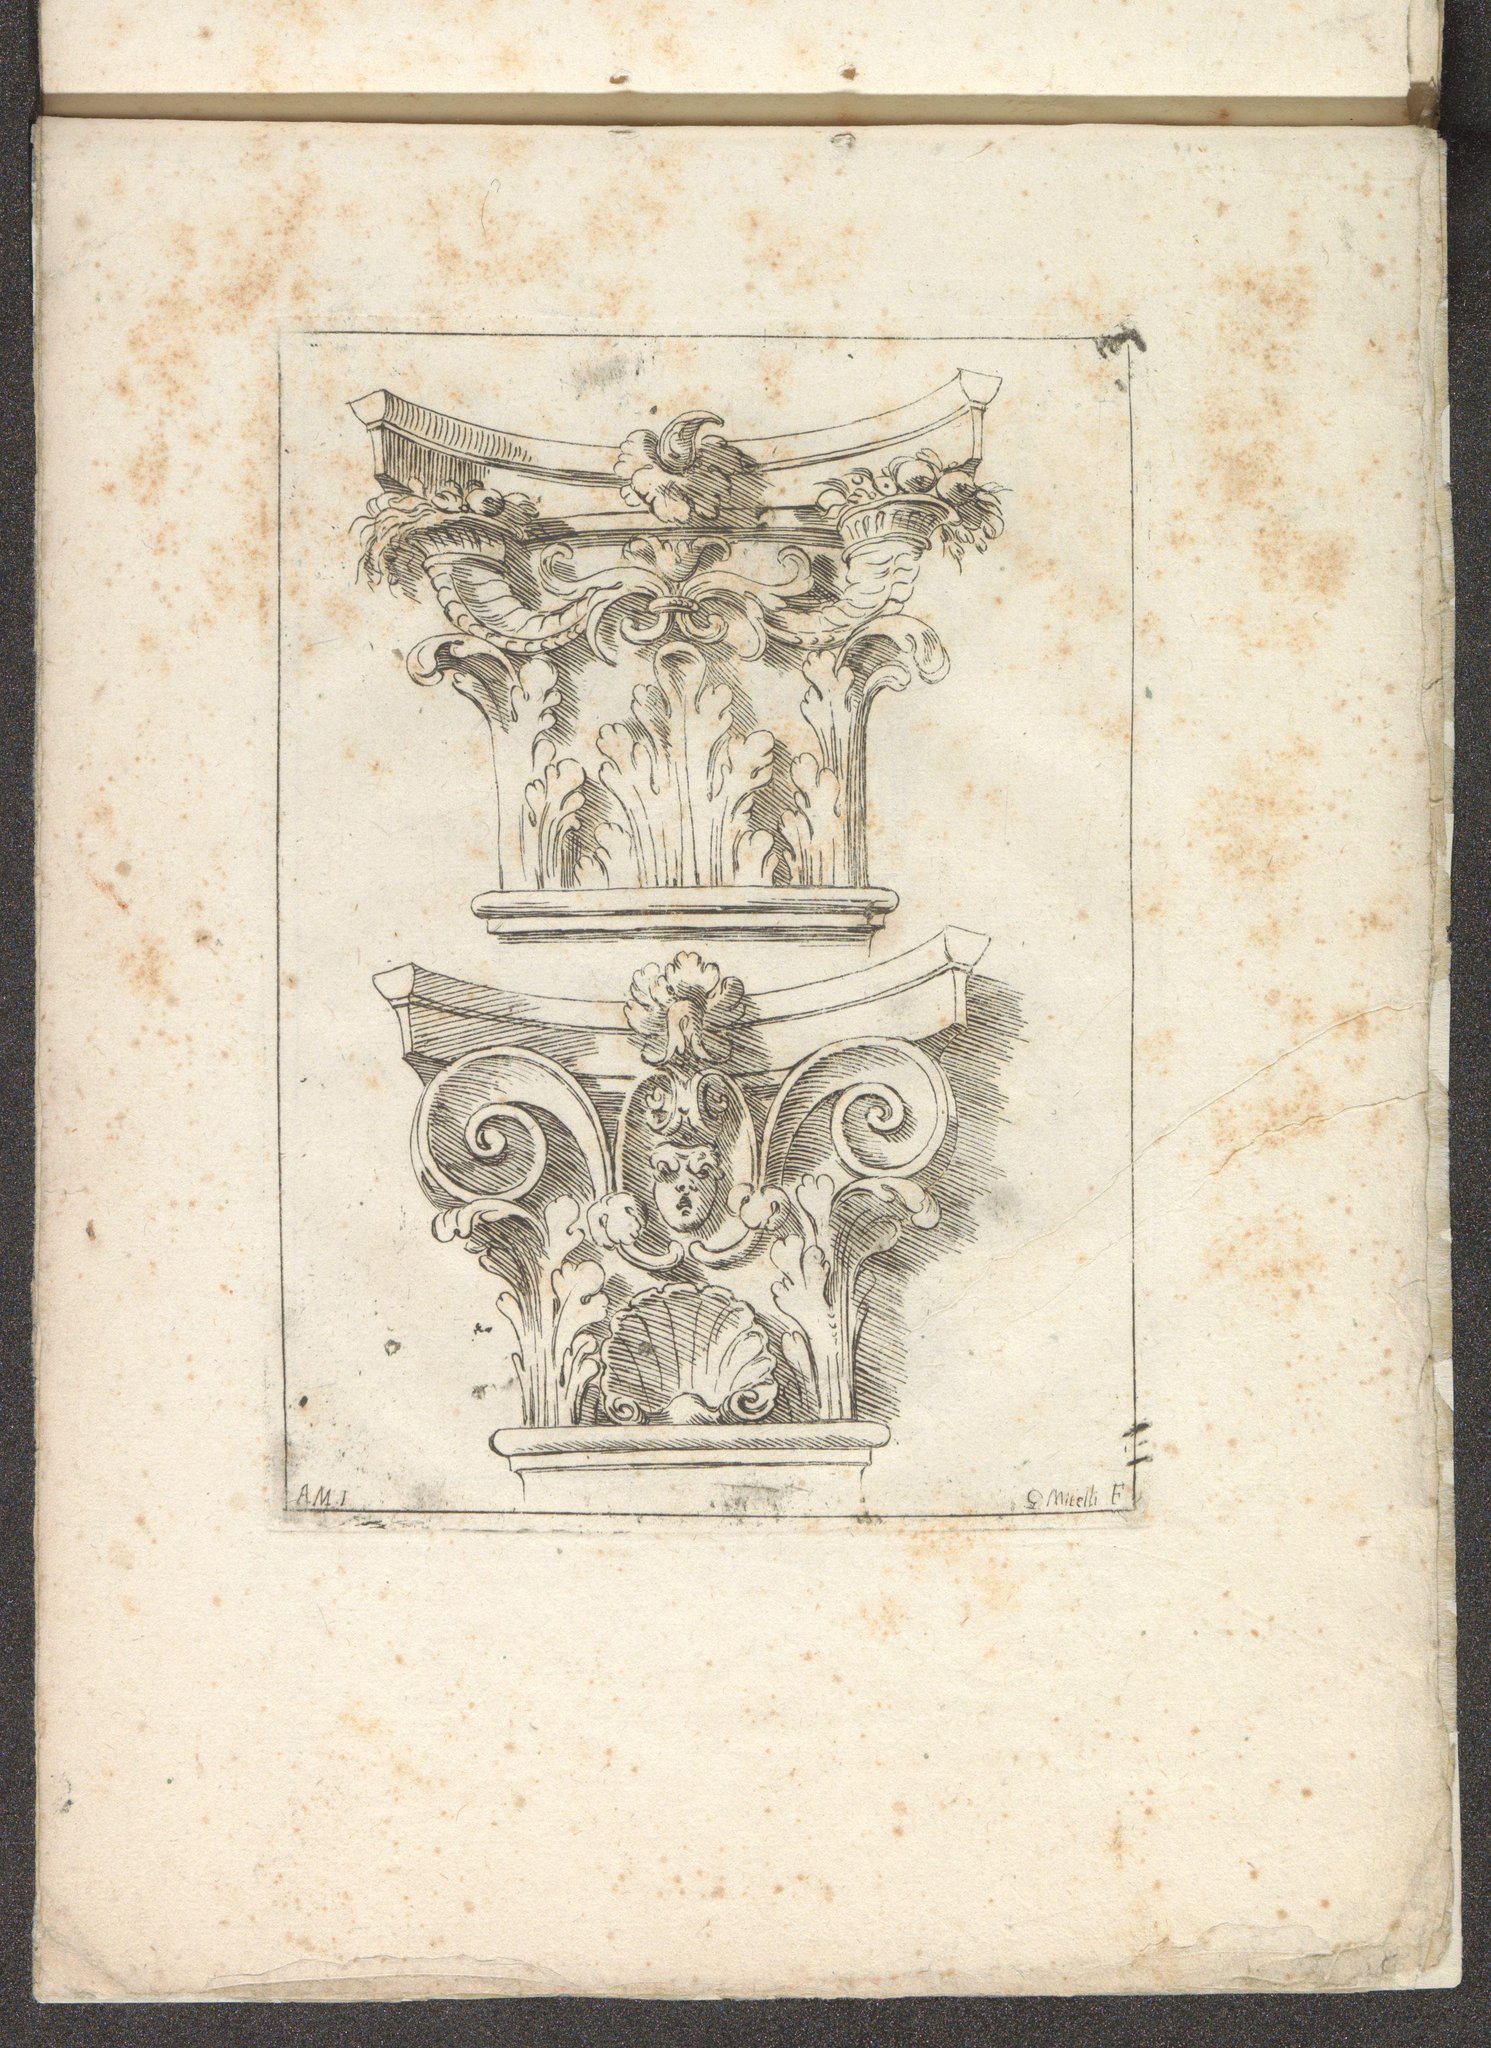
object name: print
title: Disegni, et Abbozzi di Agostino Mitelli Intagliati Dal Figluolo di Lui Gioseppe Maria Mitelli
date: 1644-1718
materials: paper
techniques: etching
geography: bologna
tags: ornaments ~ art, capital (~ column, pillar)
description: Twee ornamentele kapitelen. Het bovenste kapiteel met hoornen met vruchten. De prent maakt deel uit van een album.